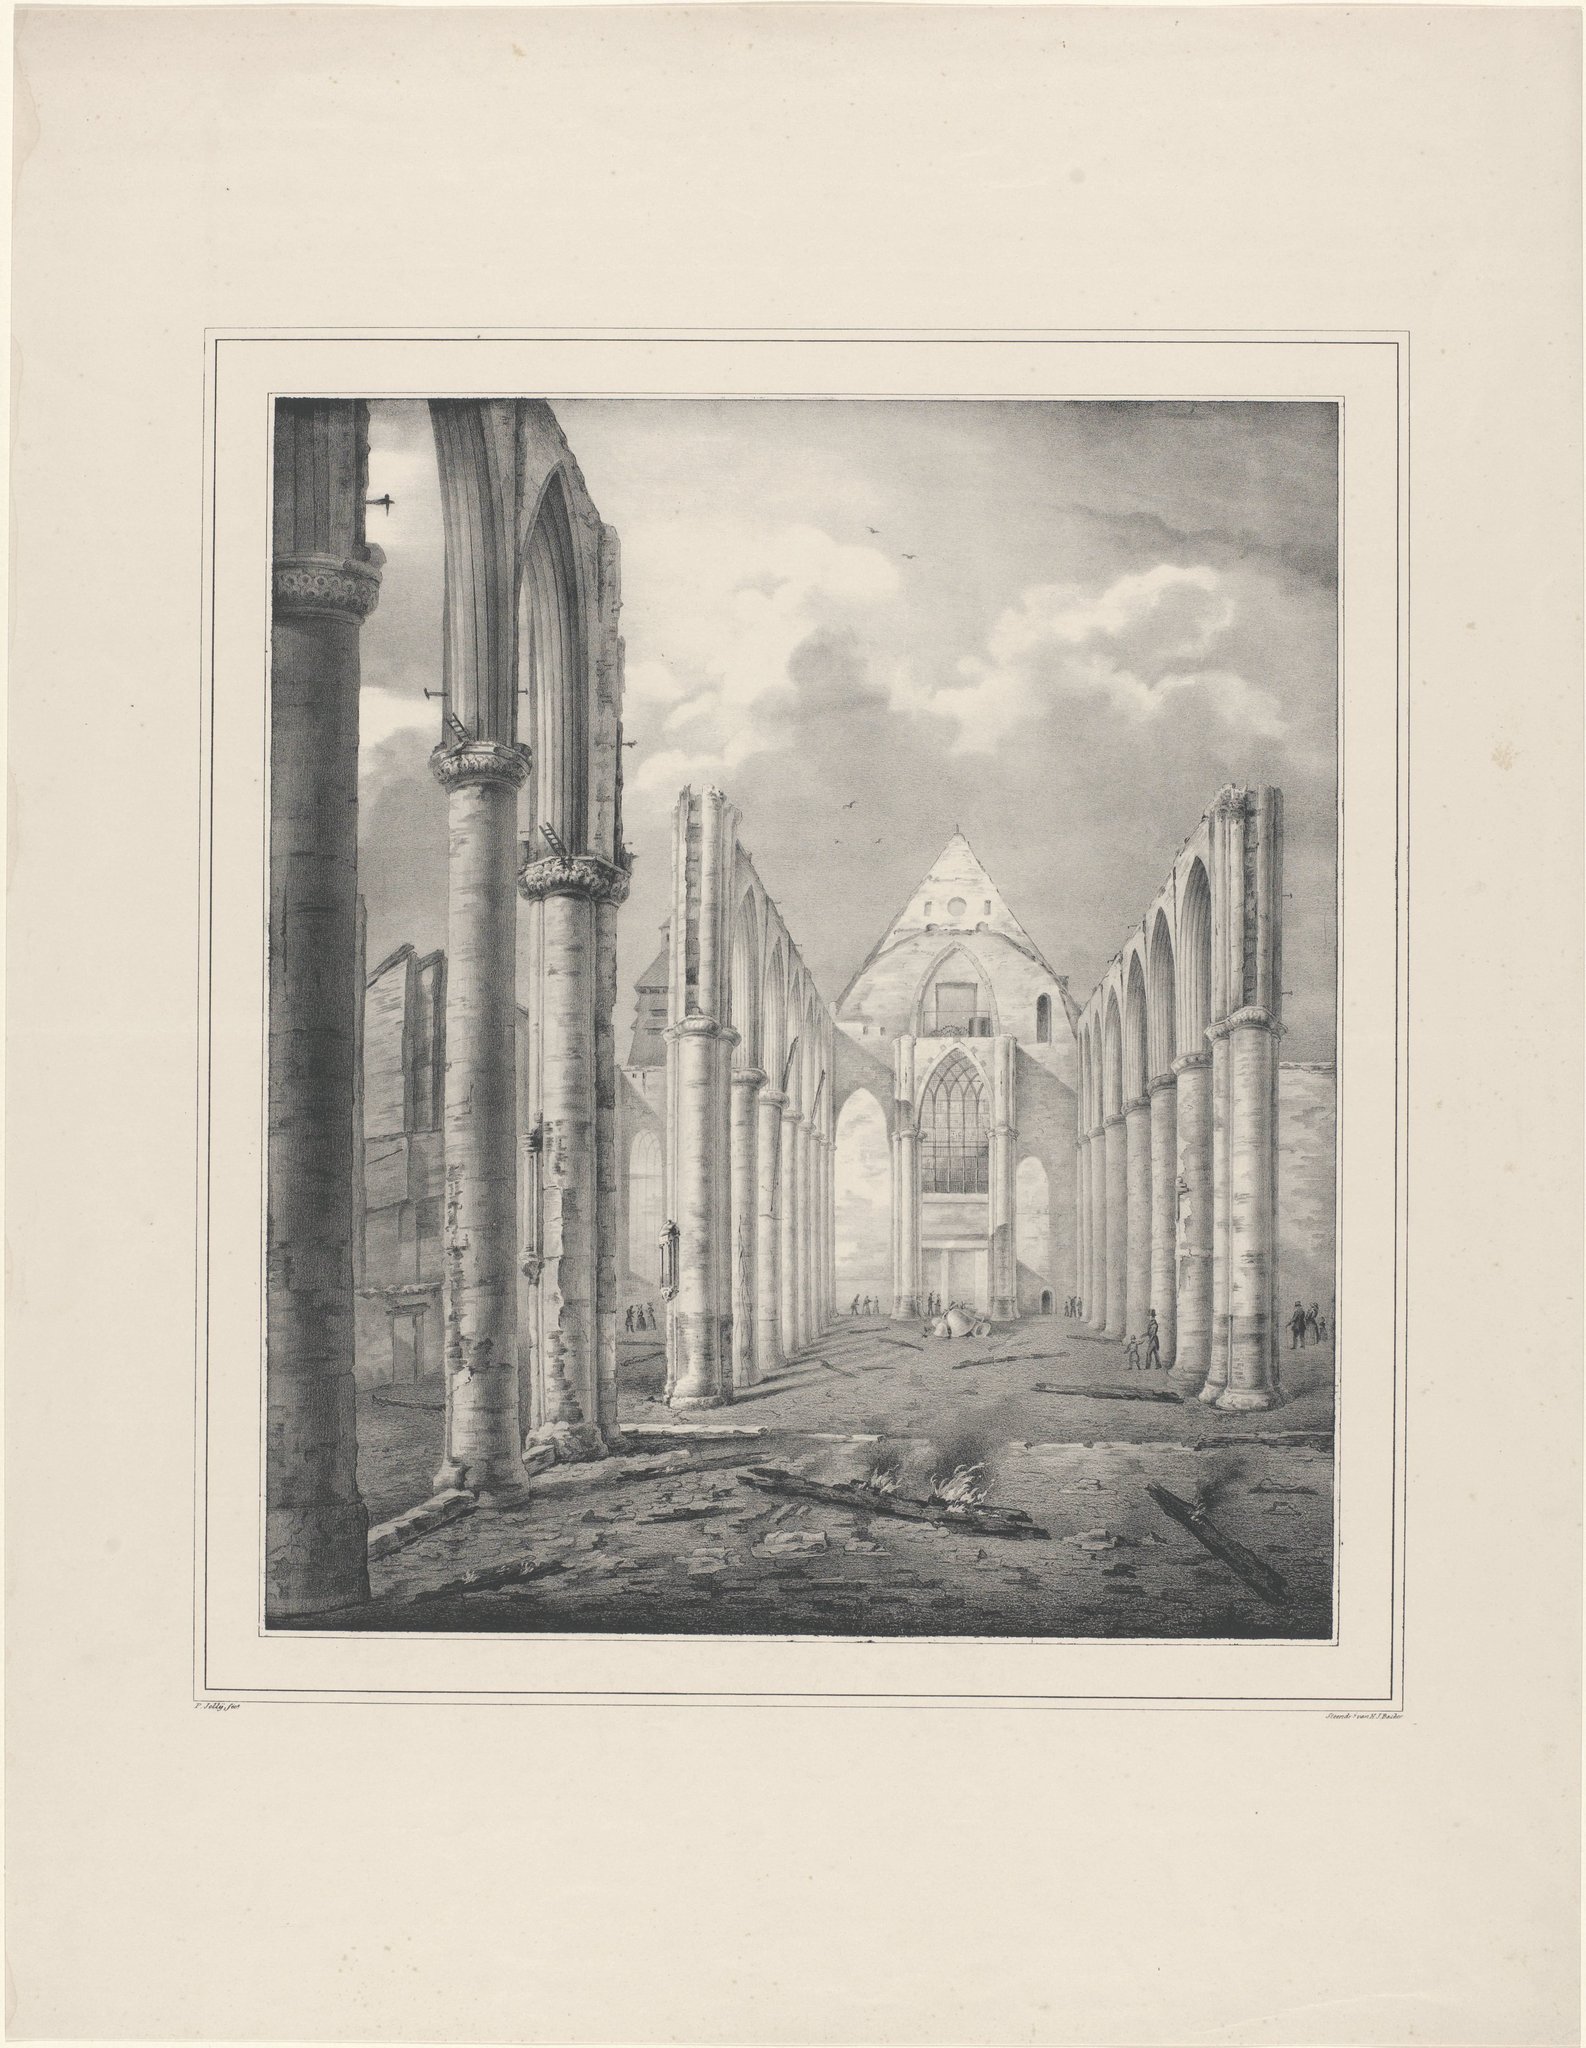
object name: print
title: Ruïne van de Grote Kerk te Hoorn, na de brand op 3 augustus 1838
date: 1838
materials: paper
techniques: lithograph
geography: netherlands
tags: ruin of church, monastery, etc., hoorn (north holland)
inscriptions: collector's mark: Lugt 2228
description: Gezicht in het verwoeste interieur van de Grote Kerk te Hoorn na de brand van 3 augustus 1838. Bezoekers lopen door de ruïnes, de kerkklokken liggen op de grond. Zie ook de pendant.